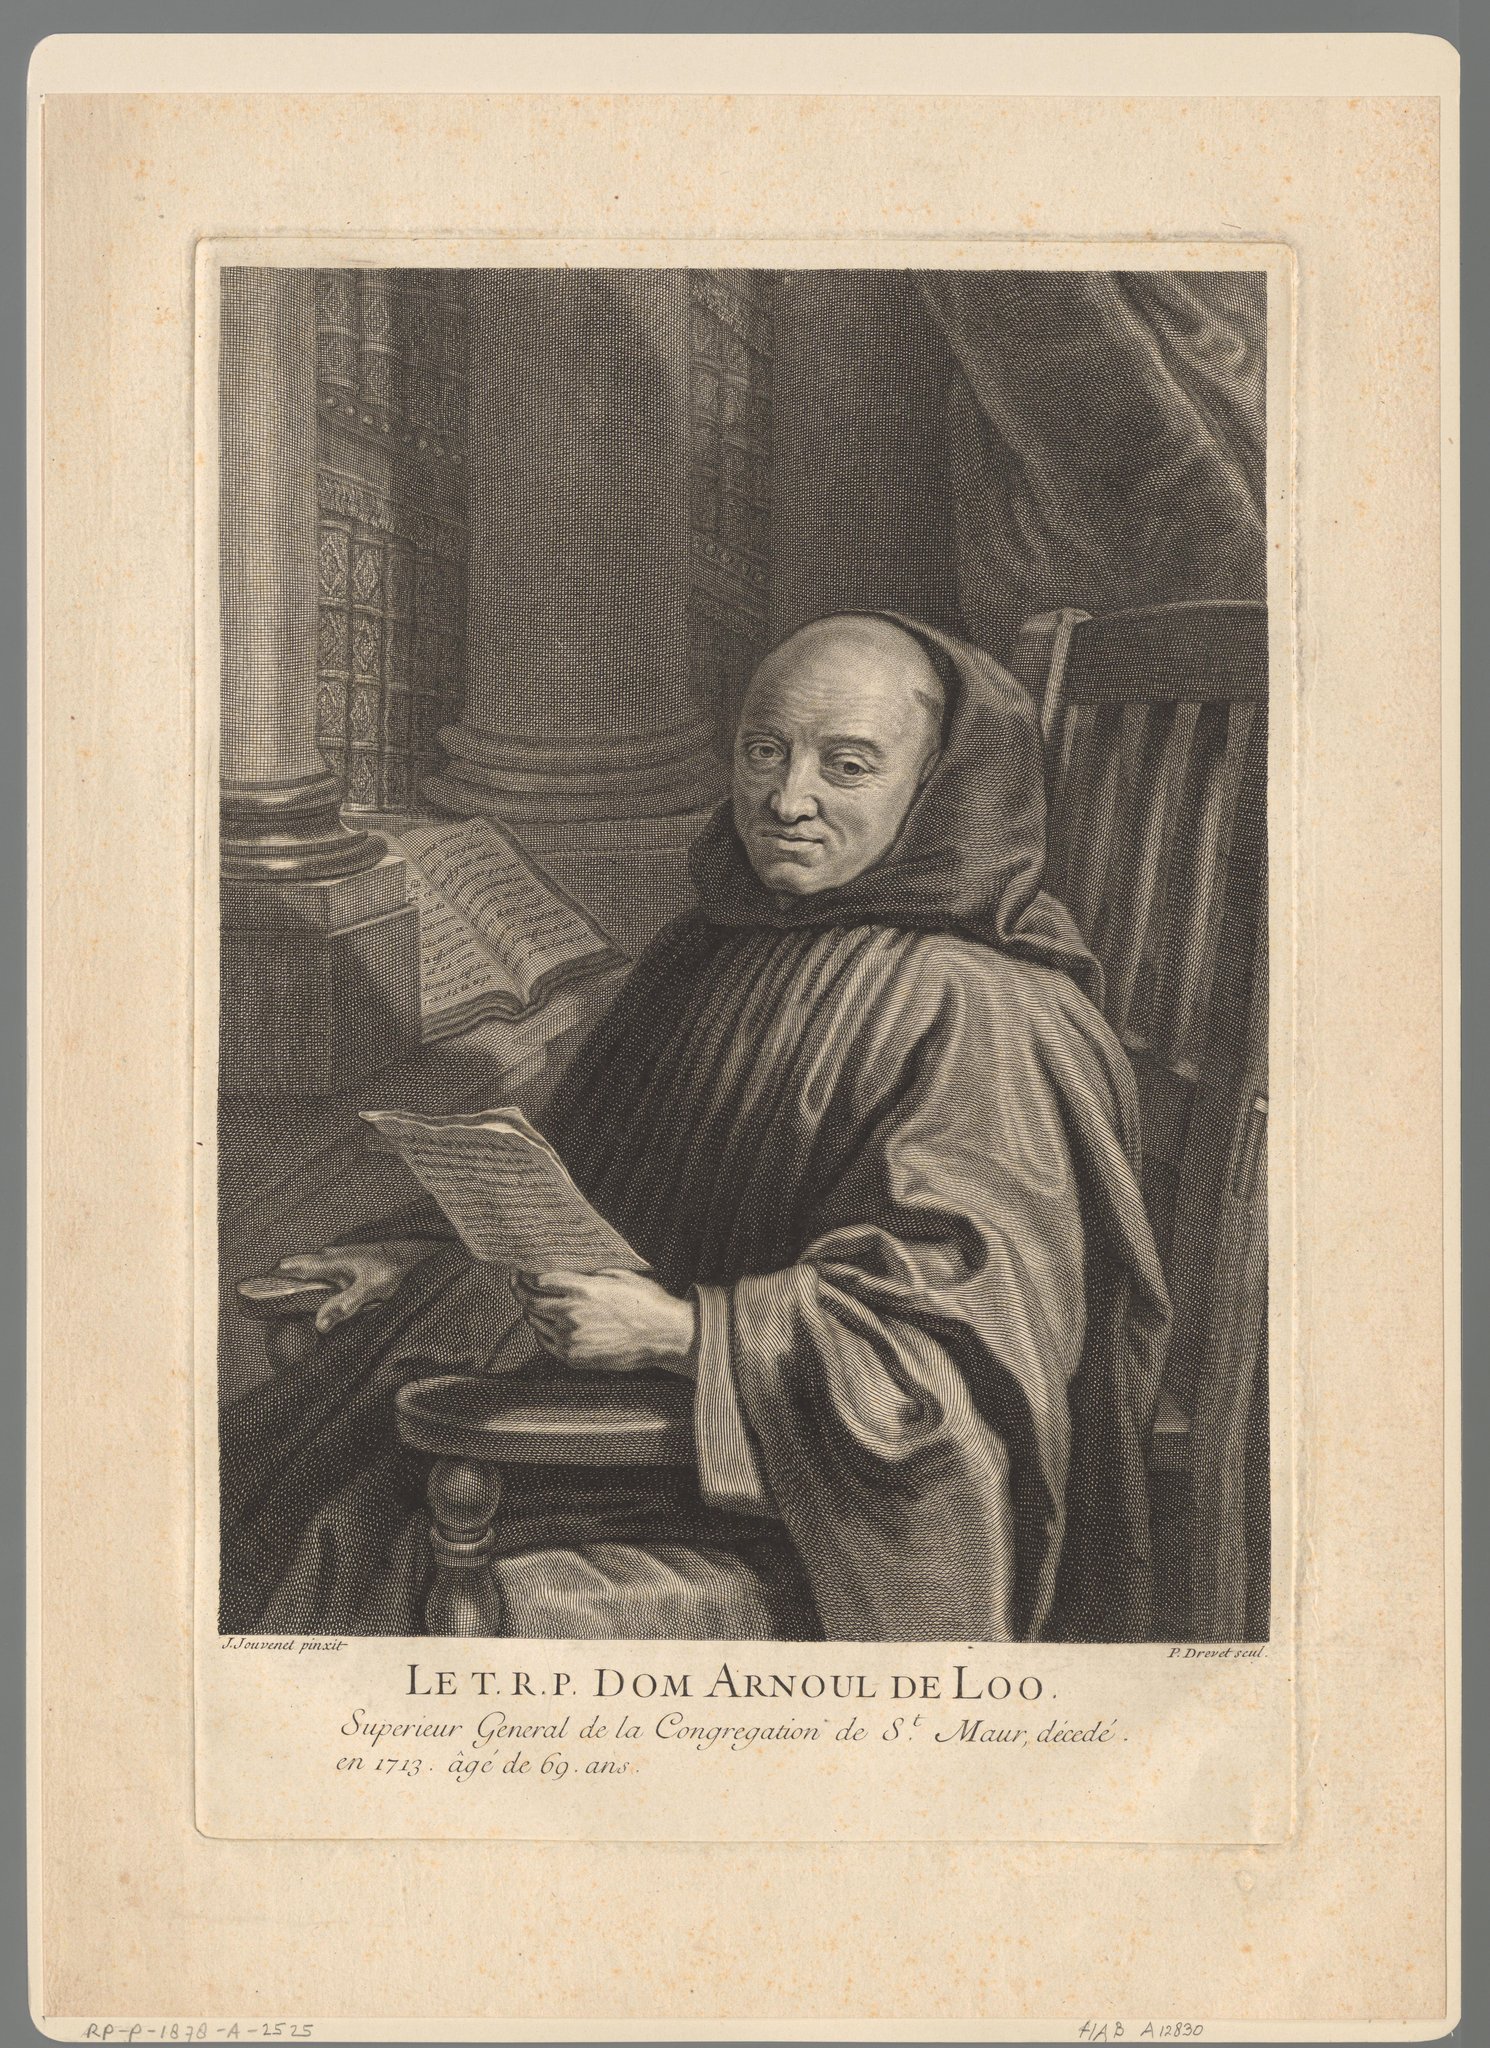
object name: print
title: Portret van Arnoul de Loo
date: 1713-1739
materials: paper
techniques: engraving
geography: france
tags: clergyman, bookshelves, reading, monastic orders, monastic life: benedictines, historical persons, monk(s), friar(s)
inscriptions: collector's mark: Lugt 2228